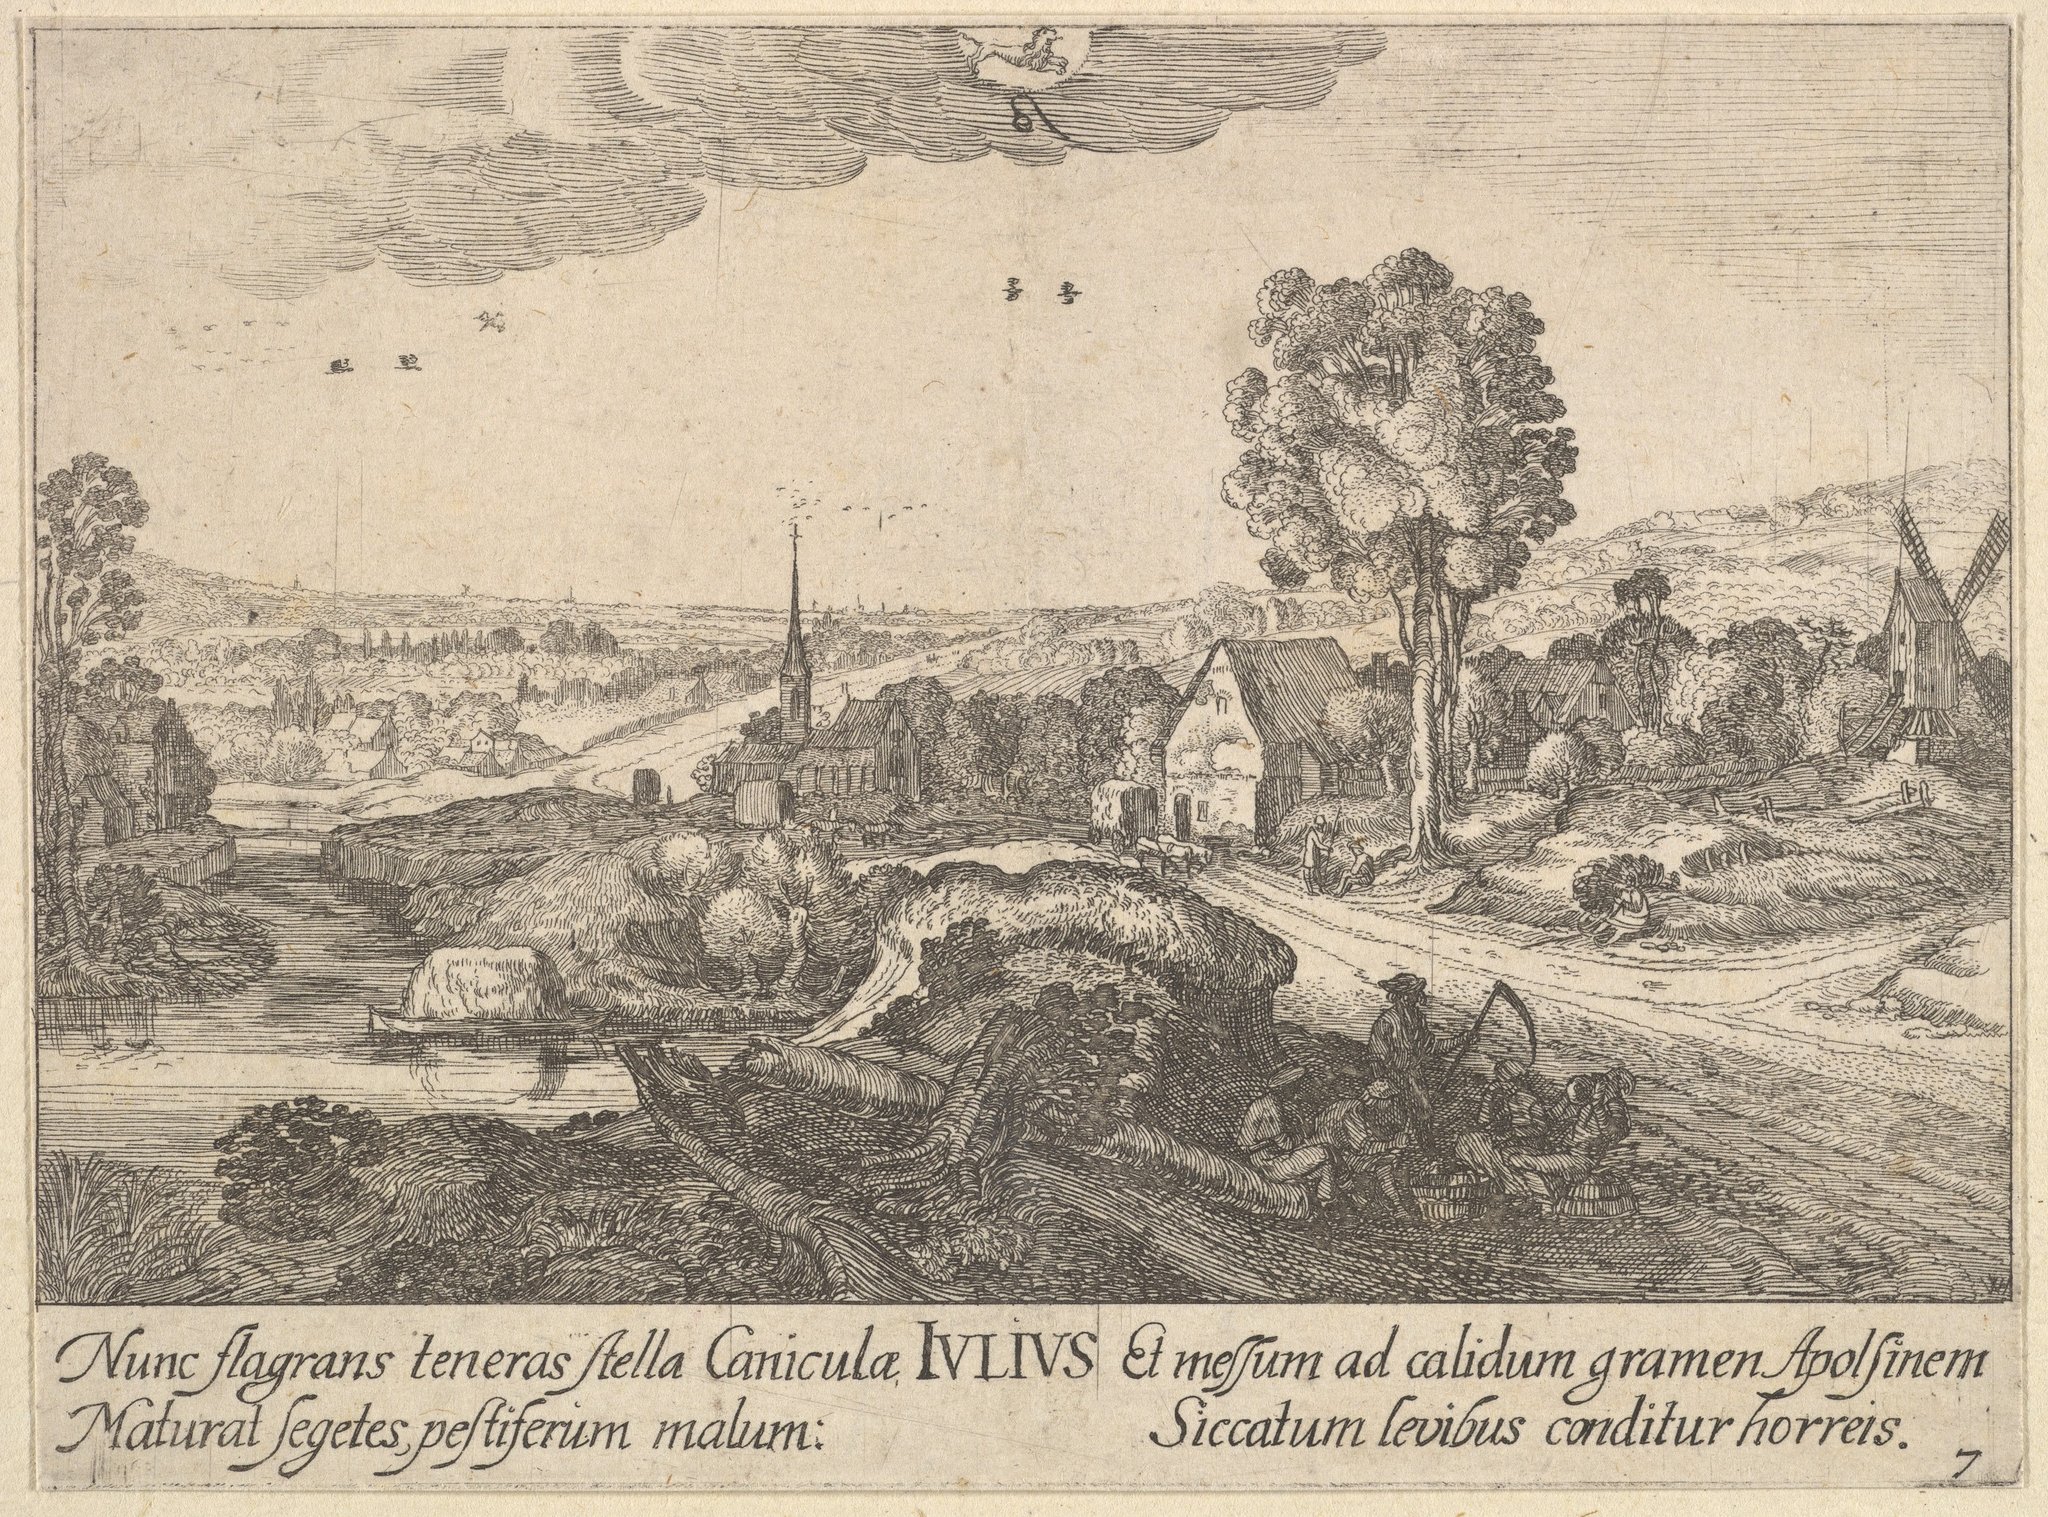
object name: print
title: July (Iulius)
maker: wenceslaus hollar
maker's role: artist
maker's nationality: bohemian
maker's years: 1607-1677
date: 1628-1629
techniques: etching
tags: human figures,villages,landscapes